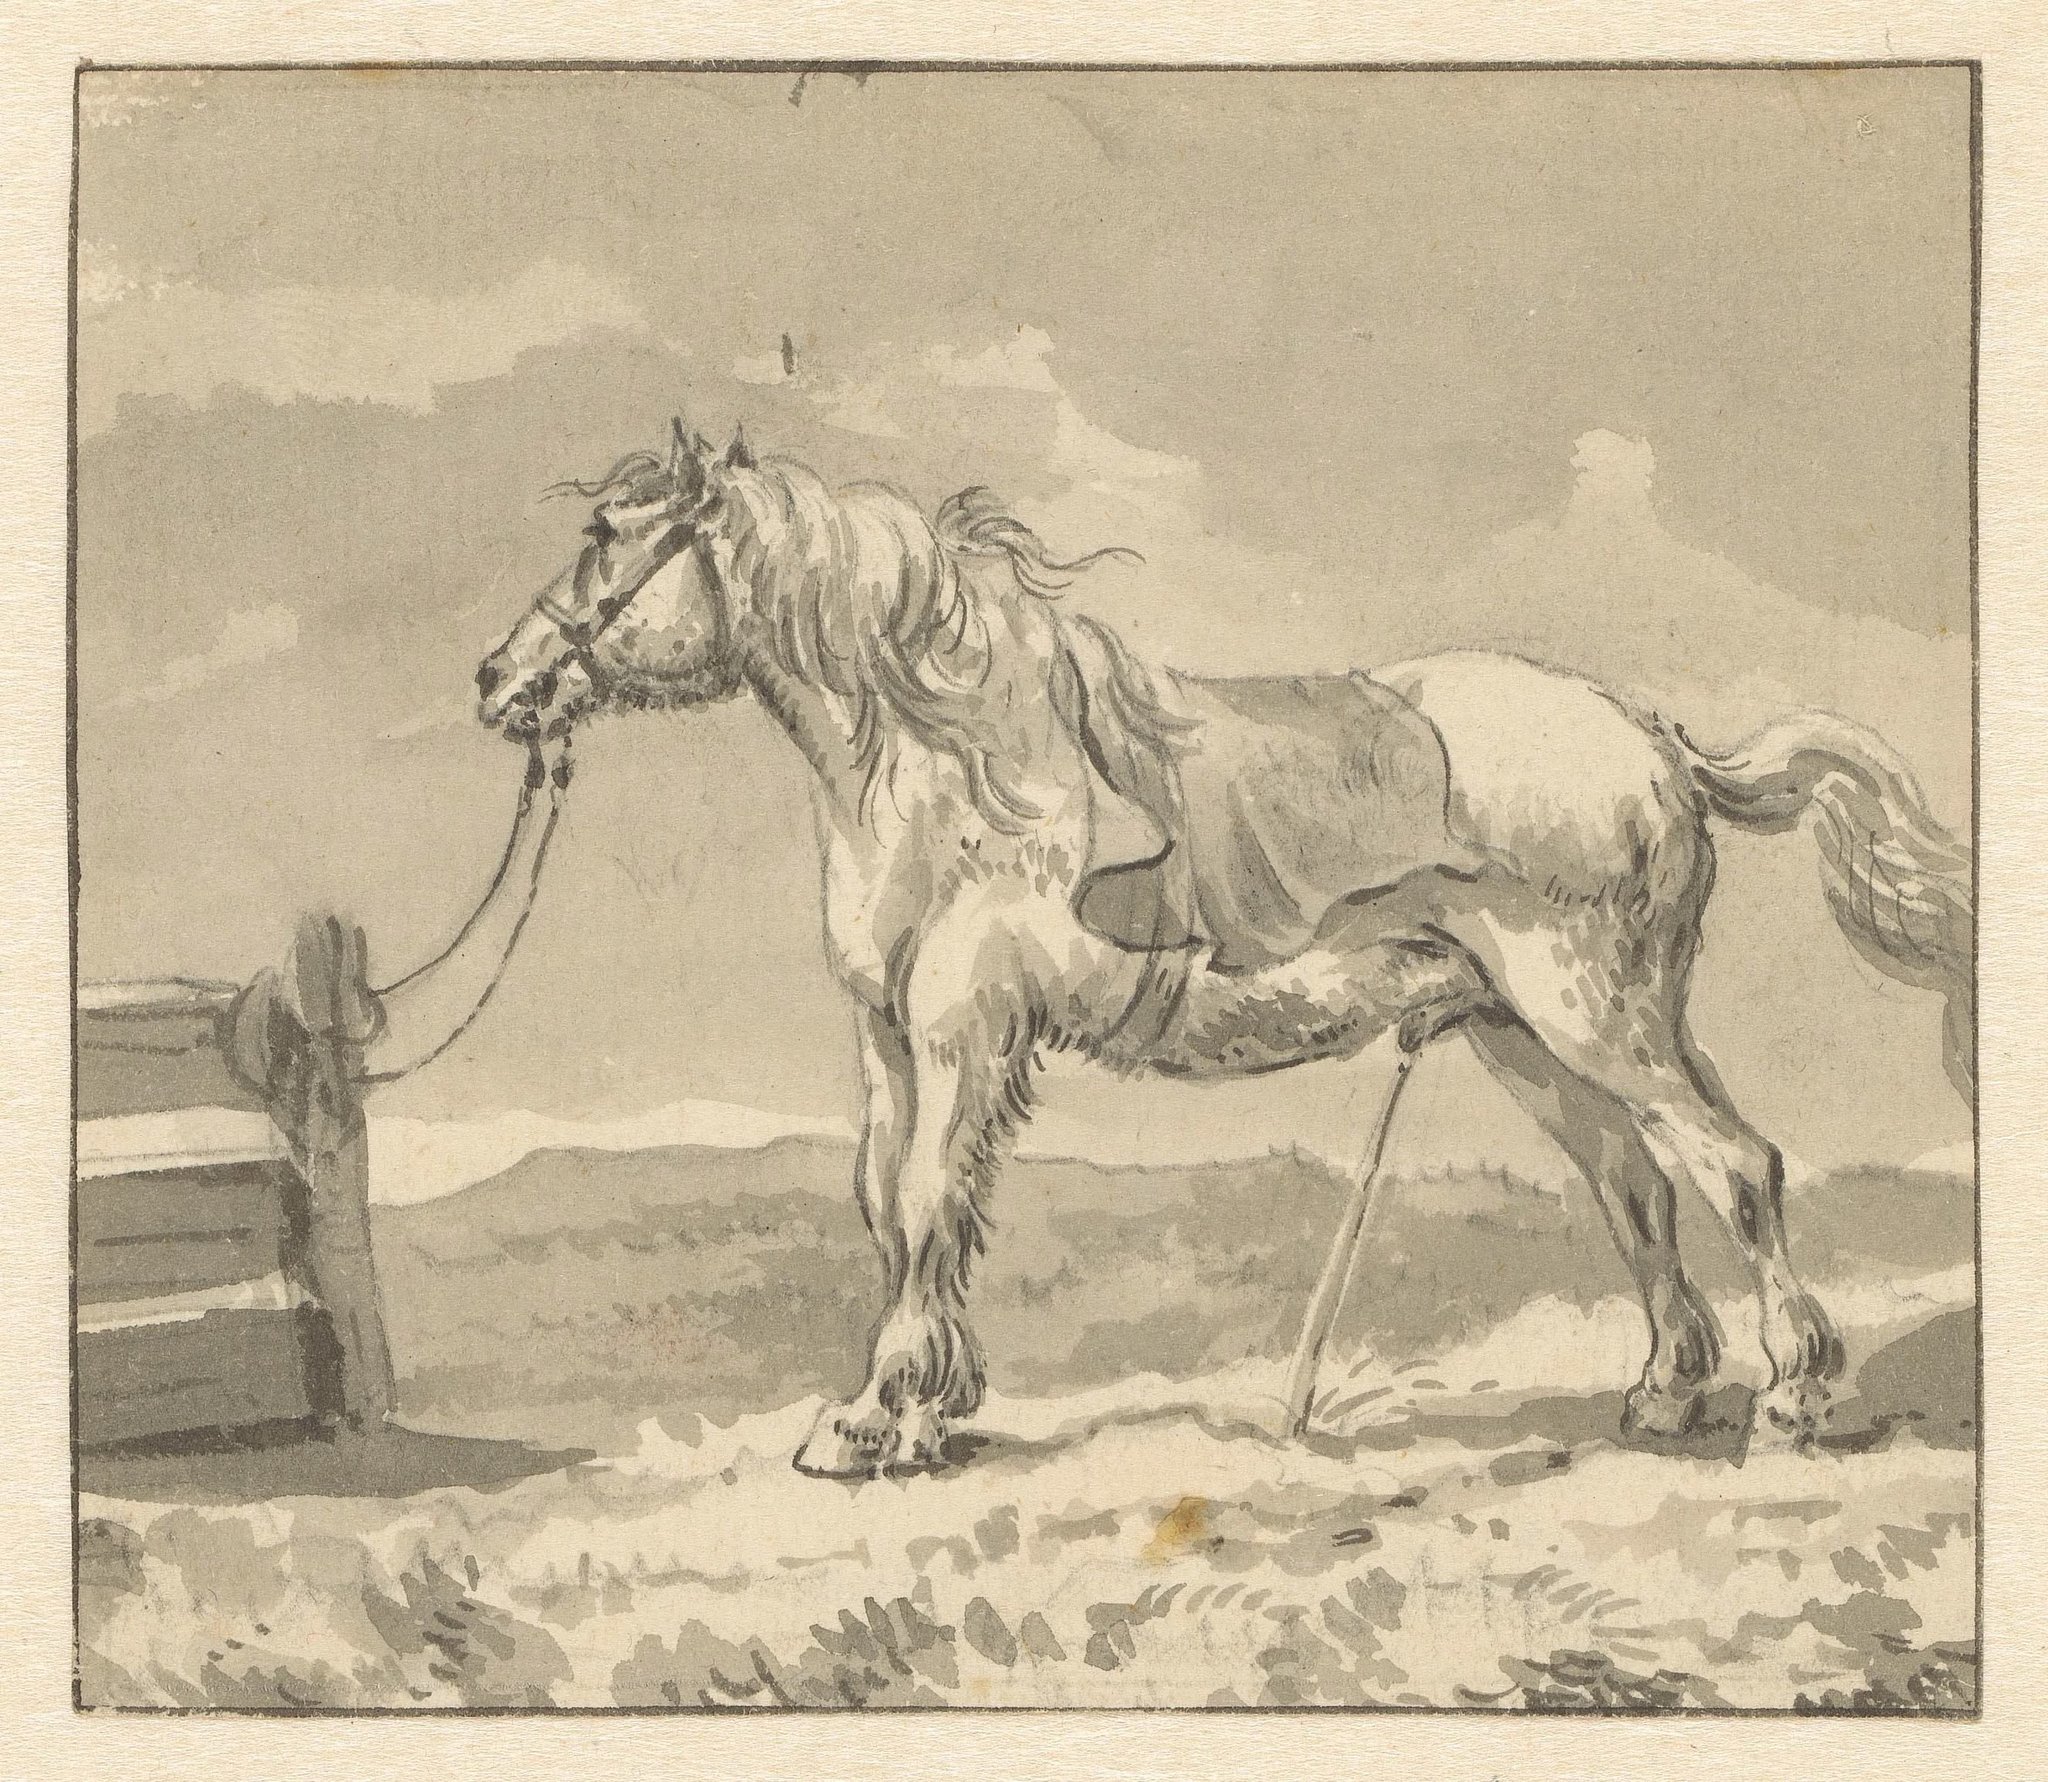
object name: drawing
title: Paard in een weiland dat aan een hek gebonden is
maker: wouter johannes van troostwijk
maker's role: draughtsman, painter, print maker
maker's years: 1782-1810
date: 1802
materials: ink, paper, pencil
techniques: brush, pen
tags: meadow, pasture, horse